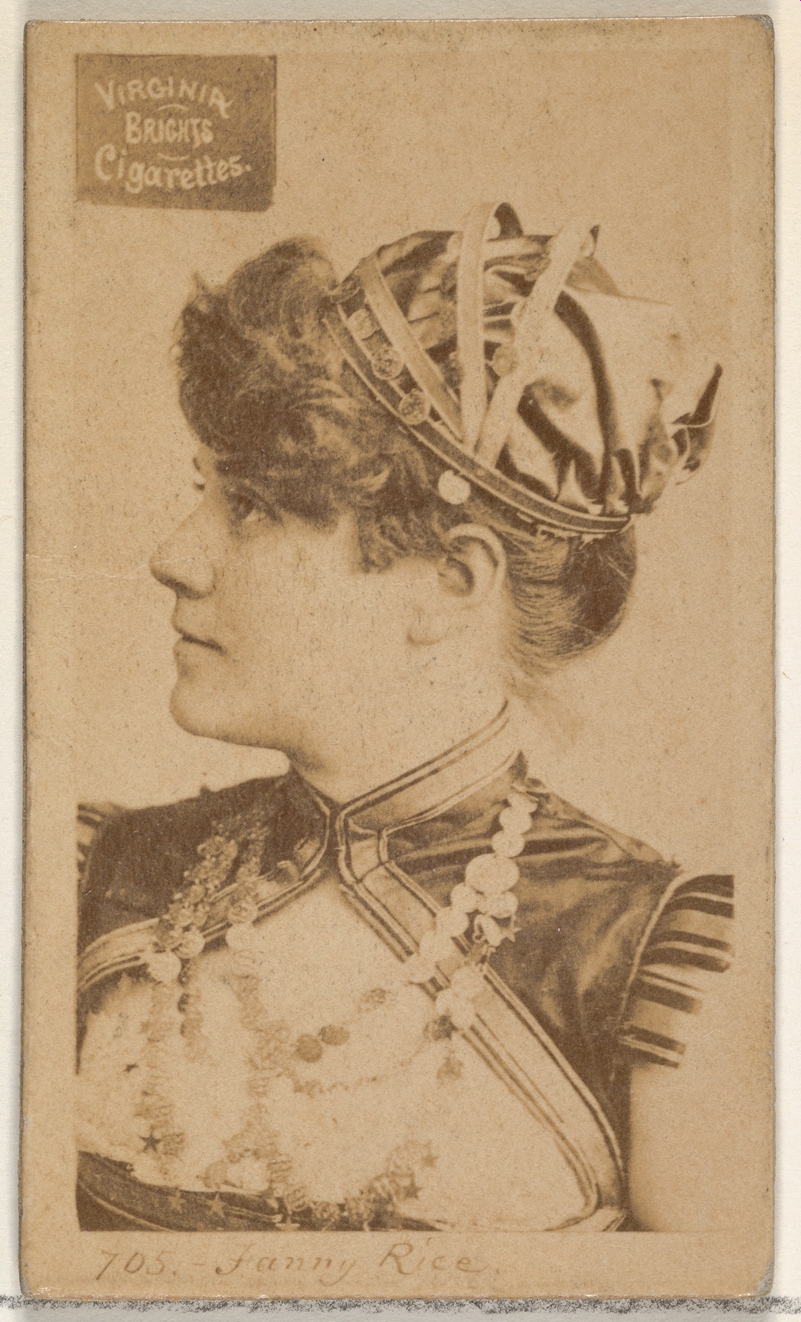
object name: photograph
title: Card 705, Fanny Rice, from the Actors and Actresses series (N45, Type 2) for Virginia Brights Cigarettes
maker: allen & ginter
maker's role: publisher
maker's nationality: american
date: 1888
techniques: albumen silver print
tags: portraits,profiles,women,actresses